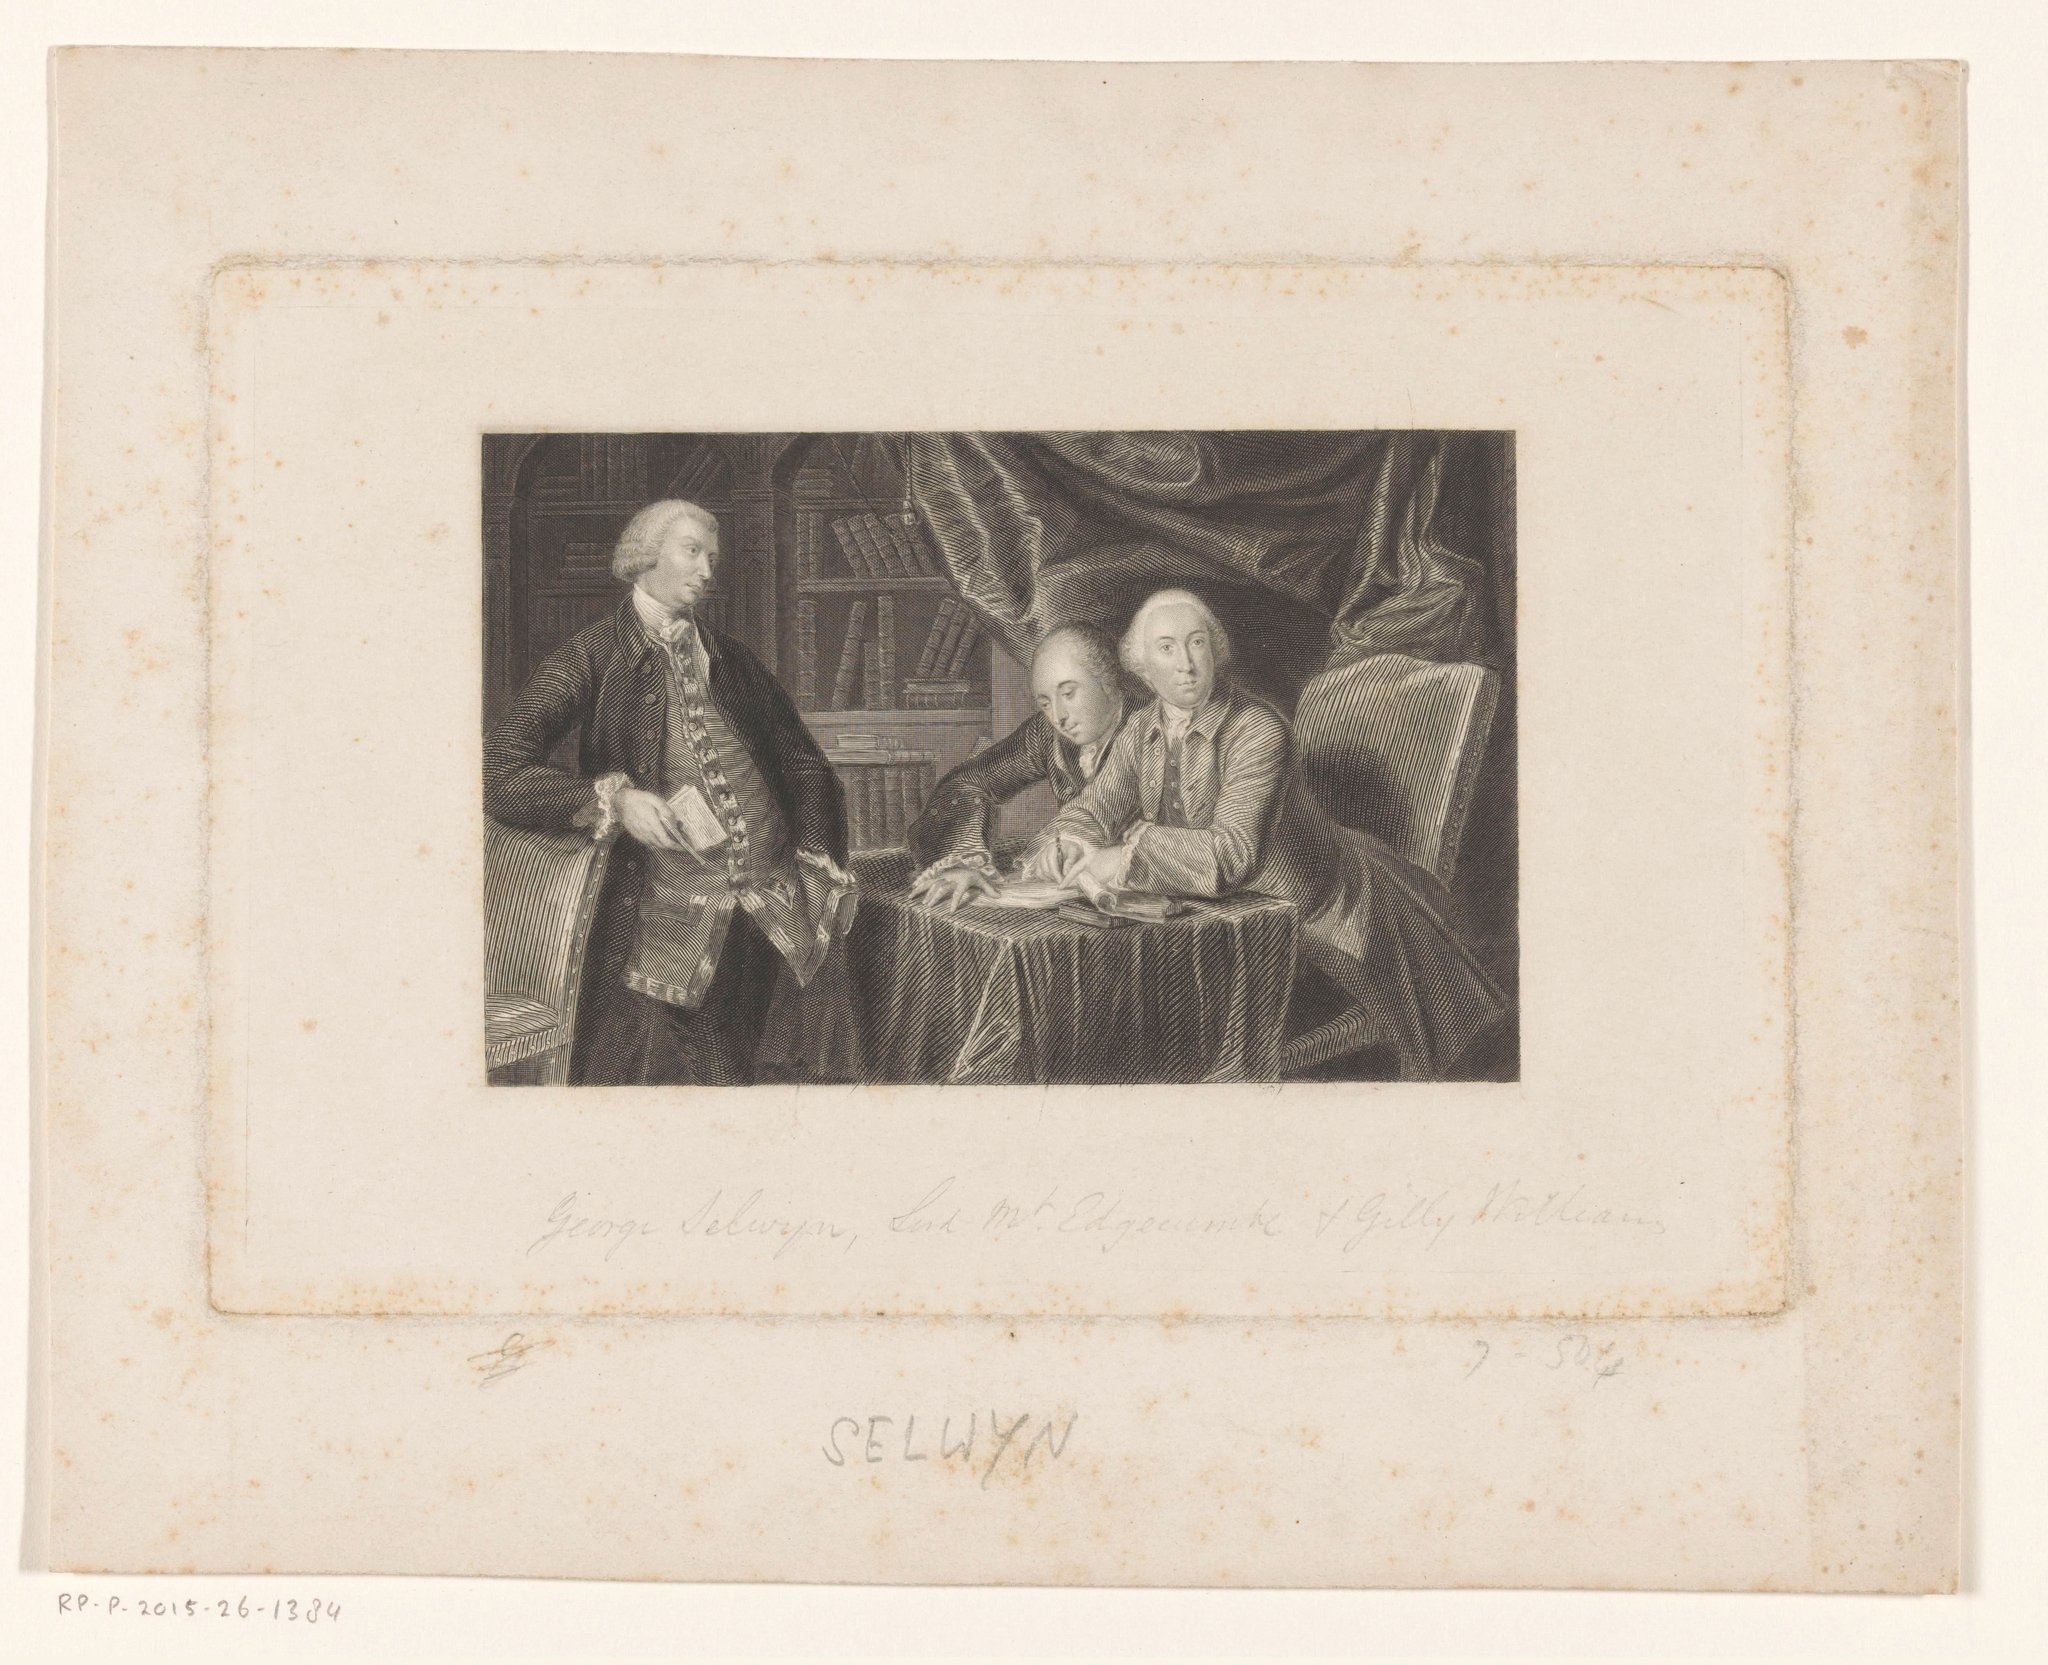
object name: print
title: Groepsportret van Richard Edgcumbe, George Augustus Selwyn en George Williams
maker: william greatbach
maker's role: print maker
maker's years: 1802-1865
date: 1812-1865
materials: paper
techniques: engraving, etching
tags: draughtsman, politician, richard edgcumbe (2e baron edgcumbe), bookshelves, study; 'studiolo'; library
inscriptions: inscription: ‘George Selwyn, Lord mr. Edgcumbe, + Gilly Williams’, collector's mark: Lugt 2228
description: Selwyn staat met zijn arm op een stoel geleund, een boek in zijn rechterhand. Aan tafel zitten Williams en Edgcumbe. De laatste kijkt op van zijn werk; een pen in zijn rechterhand. In de achtergrond een kast met boeken.